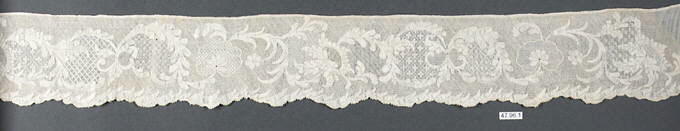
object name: strip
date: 1701-1800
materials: linen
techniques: embroidery